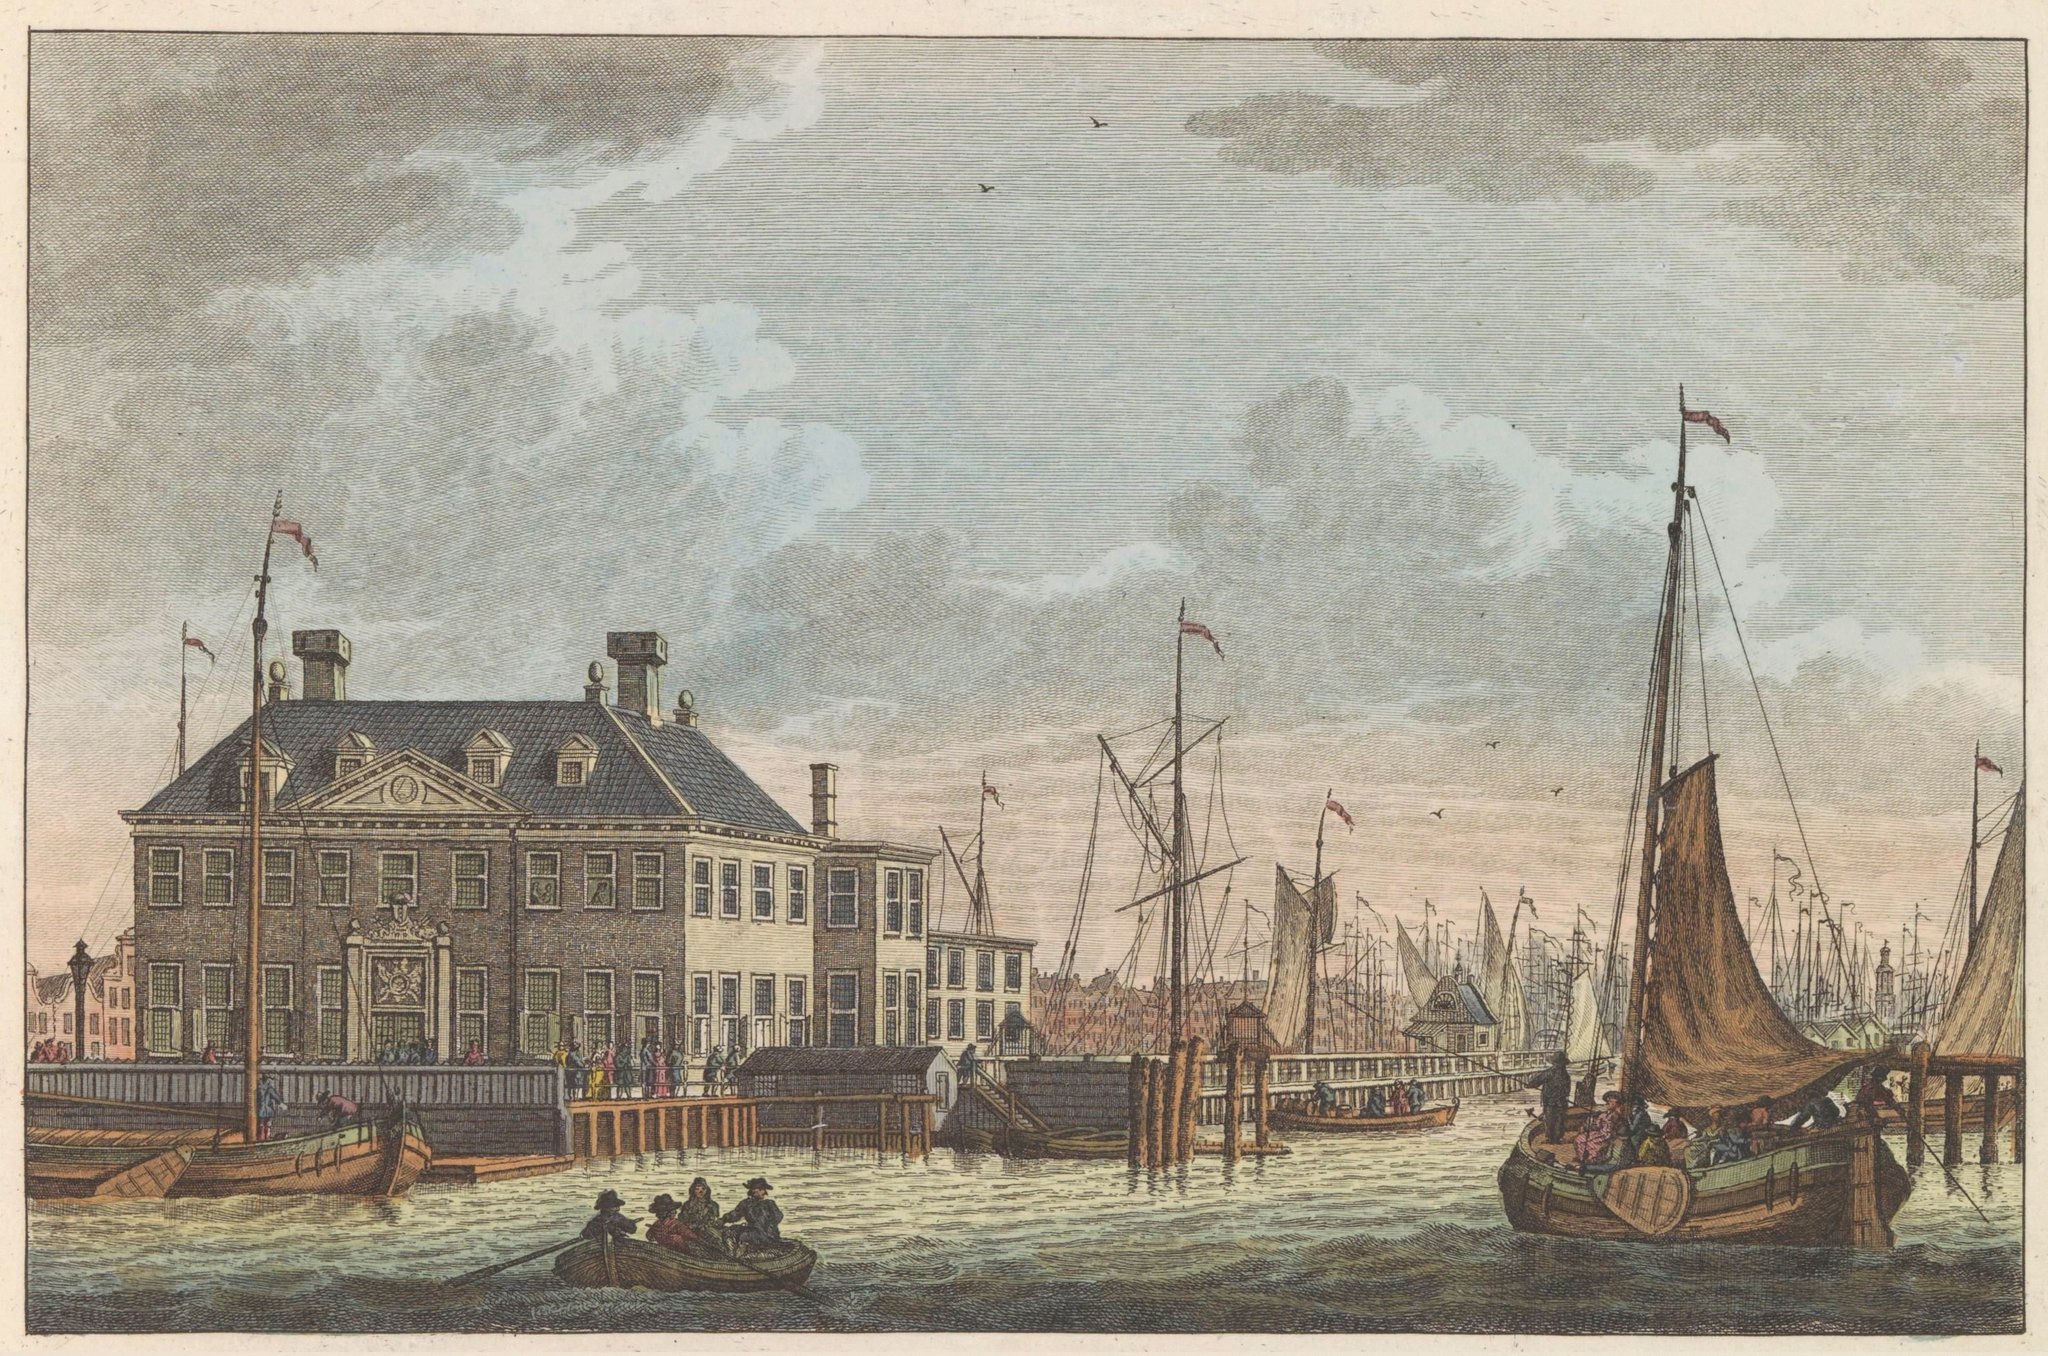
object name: print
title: Nieuwe Stads-Herberg te Amsterdam / Vue de L'Edifice dite Nieuwe Stadsherberg - passage pour le Nord-hollande et Endroite au arrive les Barques de Buiksloot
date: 1786-1792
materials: paper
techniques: engraving, etching, hand coloring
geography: amsterdam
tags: amsterdam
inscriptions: inscription: ‘Vue de L'Edifice dite Nieuwe Stadsherberg - passage pour le Nord-hollande et Endroite au arrive les Barques de Buiksloot / chez E: Maaskamp à Amsterdam’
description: Huidige staat van prent uitgegeven als onderdeel van een plaatwerk uit ca. 1824-1825 met 74 (ongenummerde) platen van de belangrijkste topografische gezichten en verschillende zeden en gewoonten in het Verenigd Koninkrijk der Nederlanden, getiteld 'Tableau des principales vues des palais et édifices : représentations et des coutumes et usages, dans les provinces septentrionales du Royaume des Pays-Bas'. Eerdere staat gebruikt in: Vaderlandsche gezichten, of afbeeldingen van den tegenwoordigen staat der Vereenigde Nederlanden (…). Amsterdam: Hendrik Gartman, Willem Vermandel en Jan Willem Smit, 1786-1792. Uitgegeven in afleveringen met ieder een eigen bifolium en inhoudsopgave. Alle prenten in deze publicatie zijn gegraveerd door Carel Frederik Bendorp (I) en, in de meeste gevallen, gebaseerd op tekeningen van Jan Bulthuis.